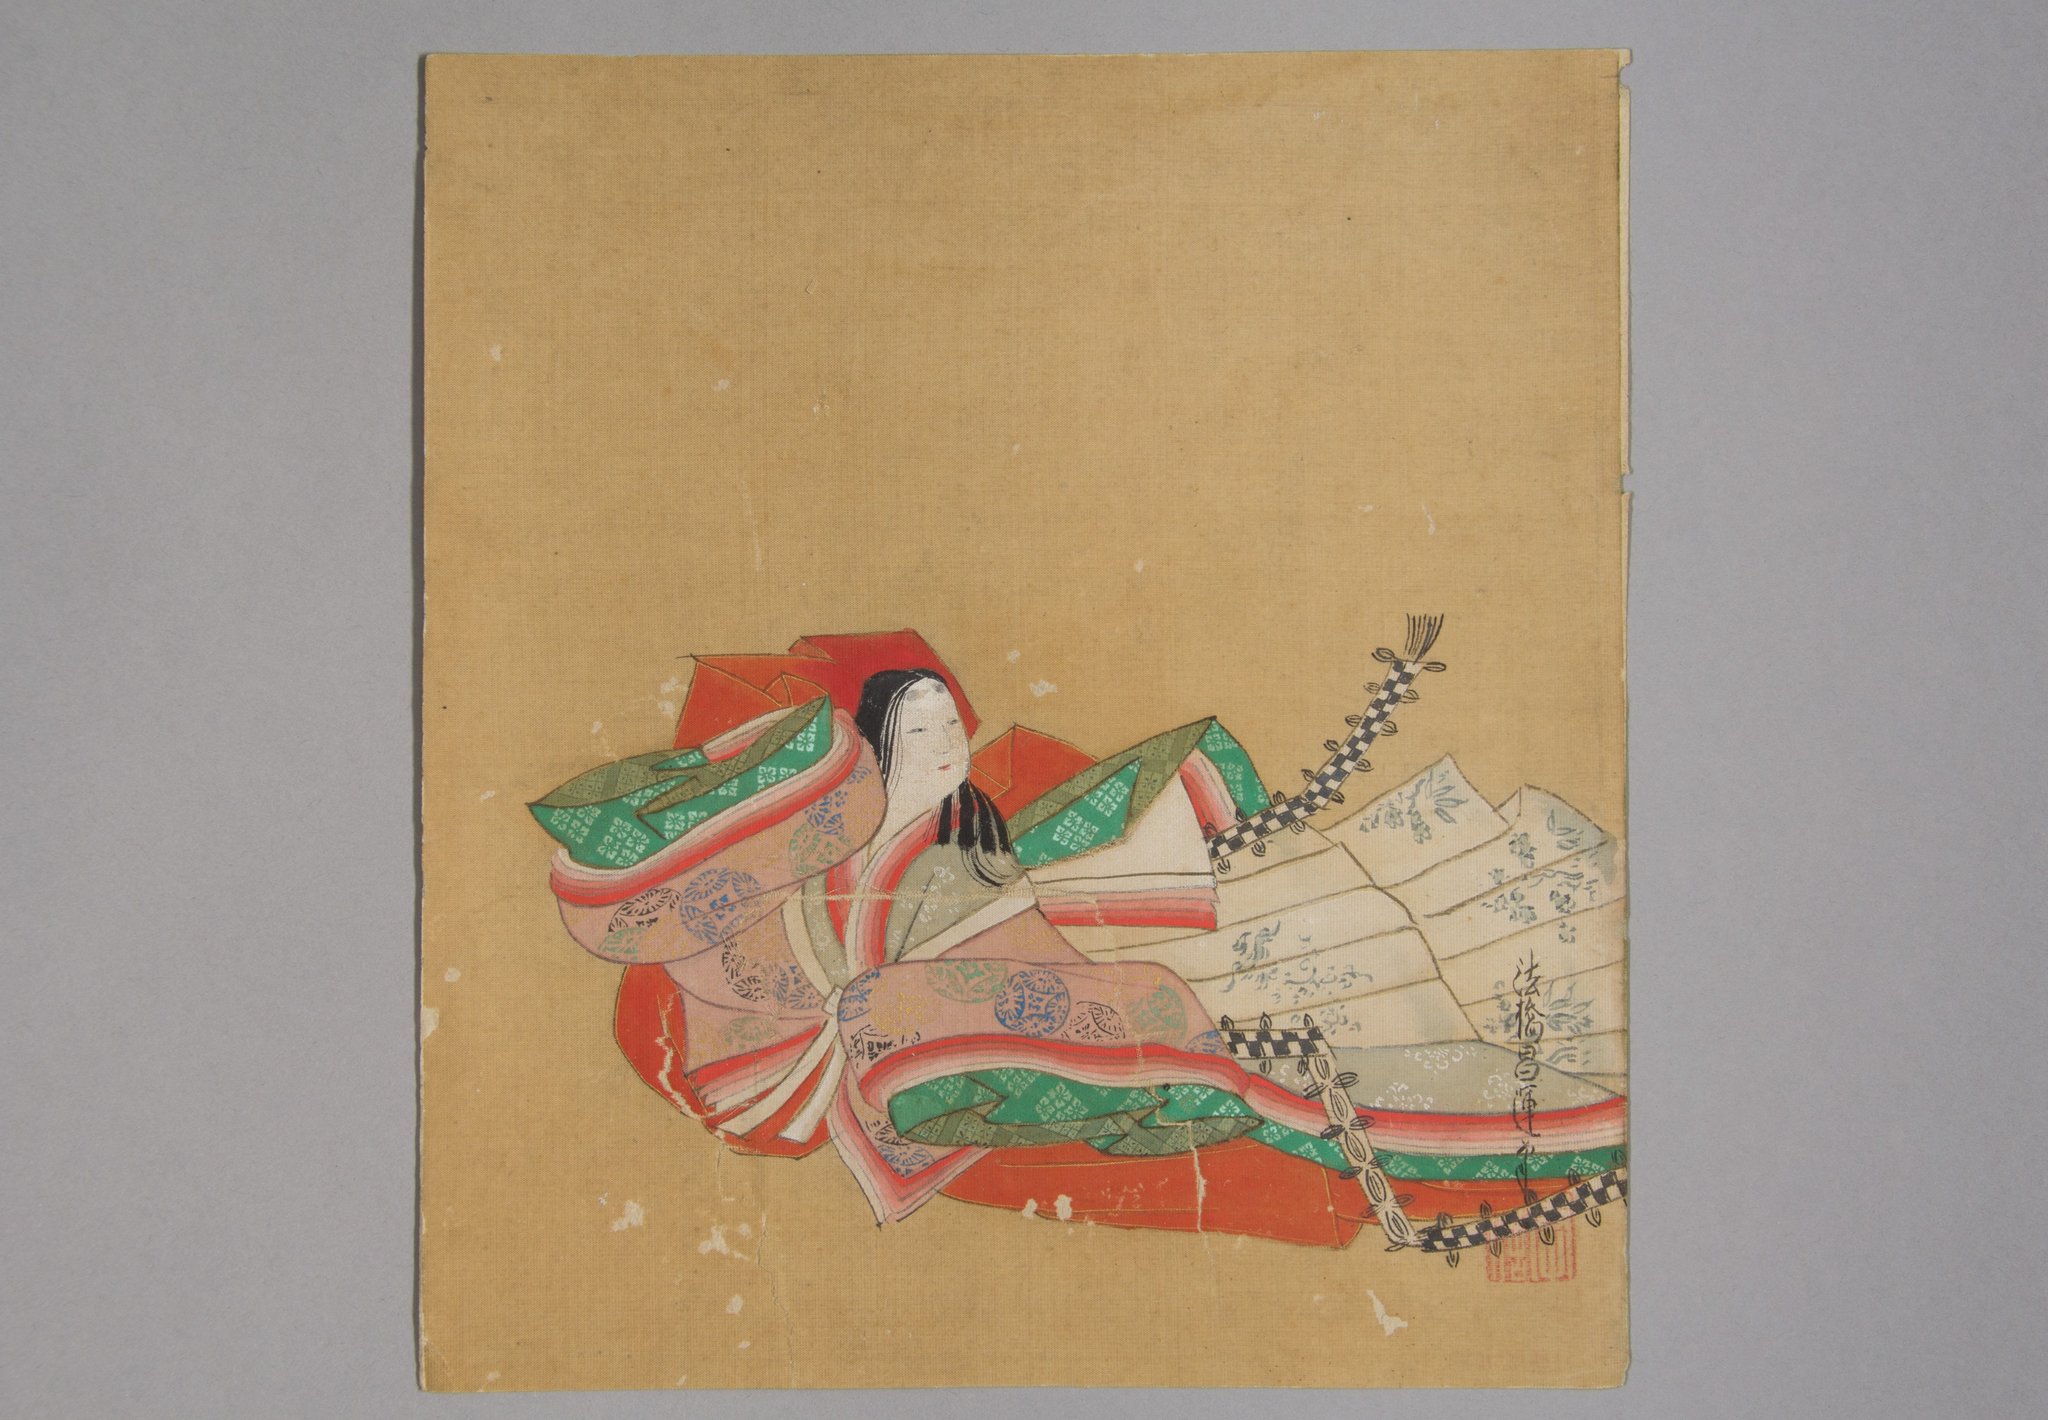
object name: painting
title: Immortal Poet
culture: japanese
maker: kano shōun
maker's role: artist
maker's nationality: japanese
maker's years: 1637-1702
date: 1601-1700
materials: ink, silk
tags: women,poets